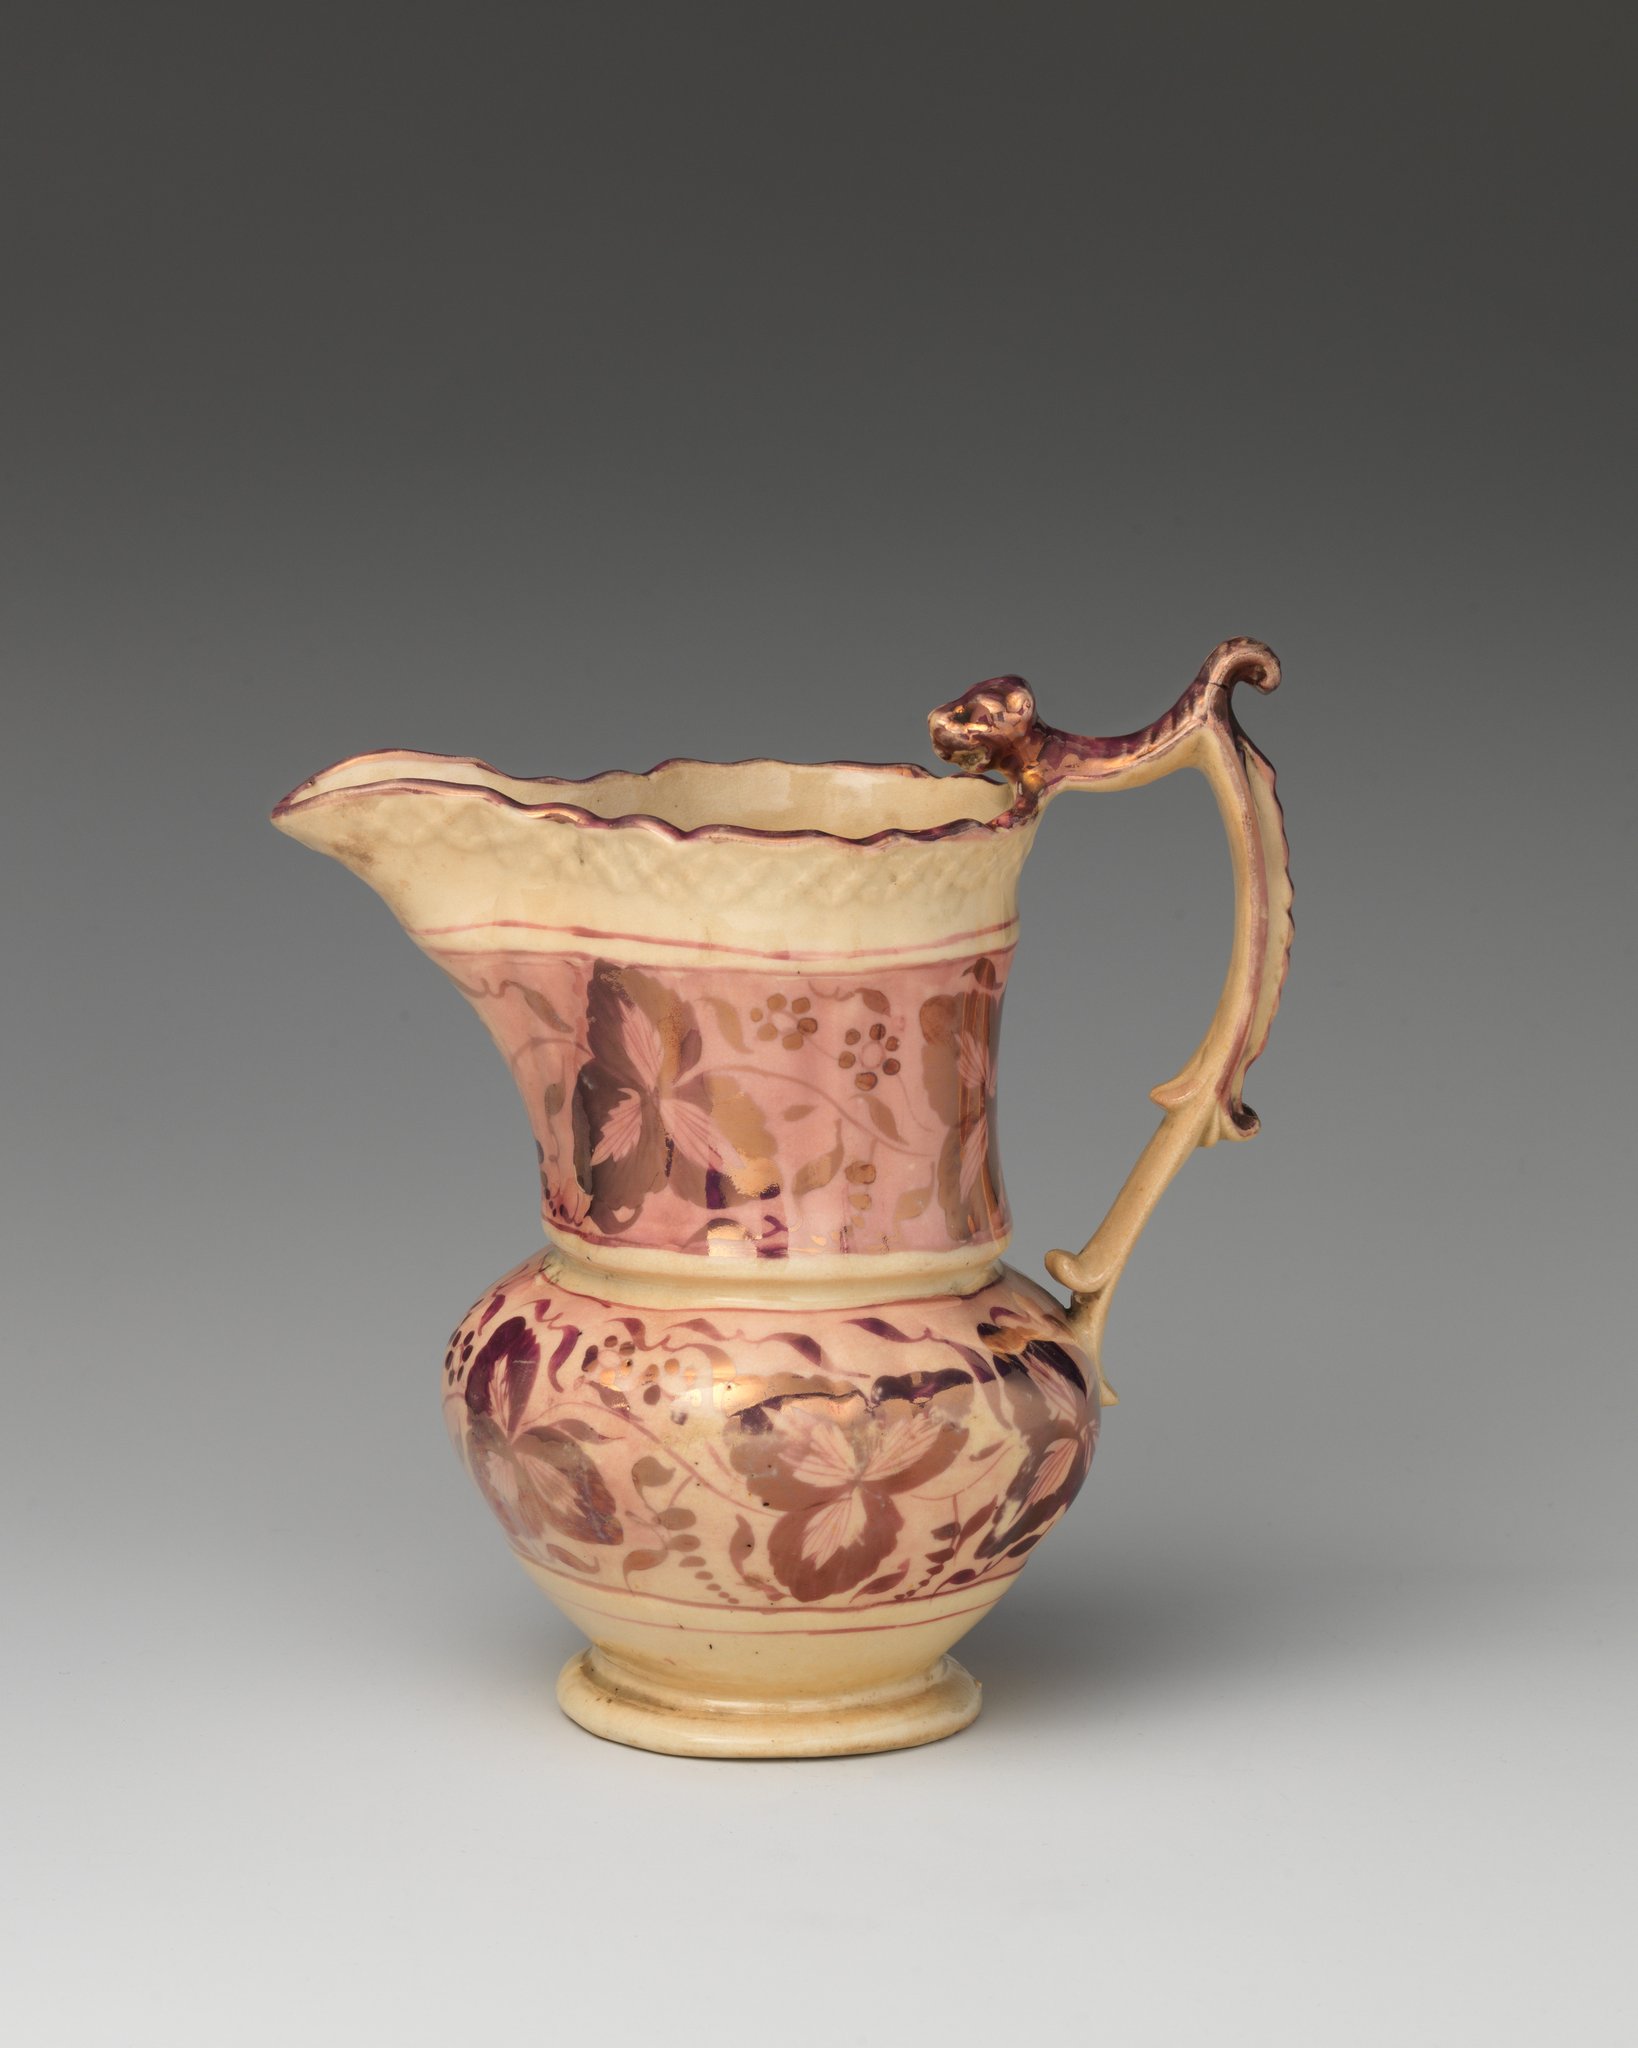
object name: cream jug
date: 1801-1900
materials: earthenware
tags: animals,flowers